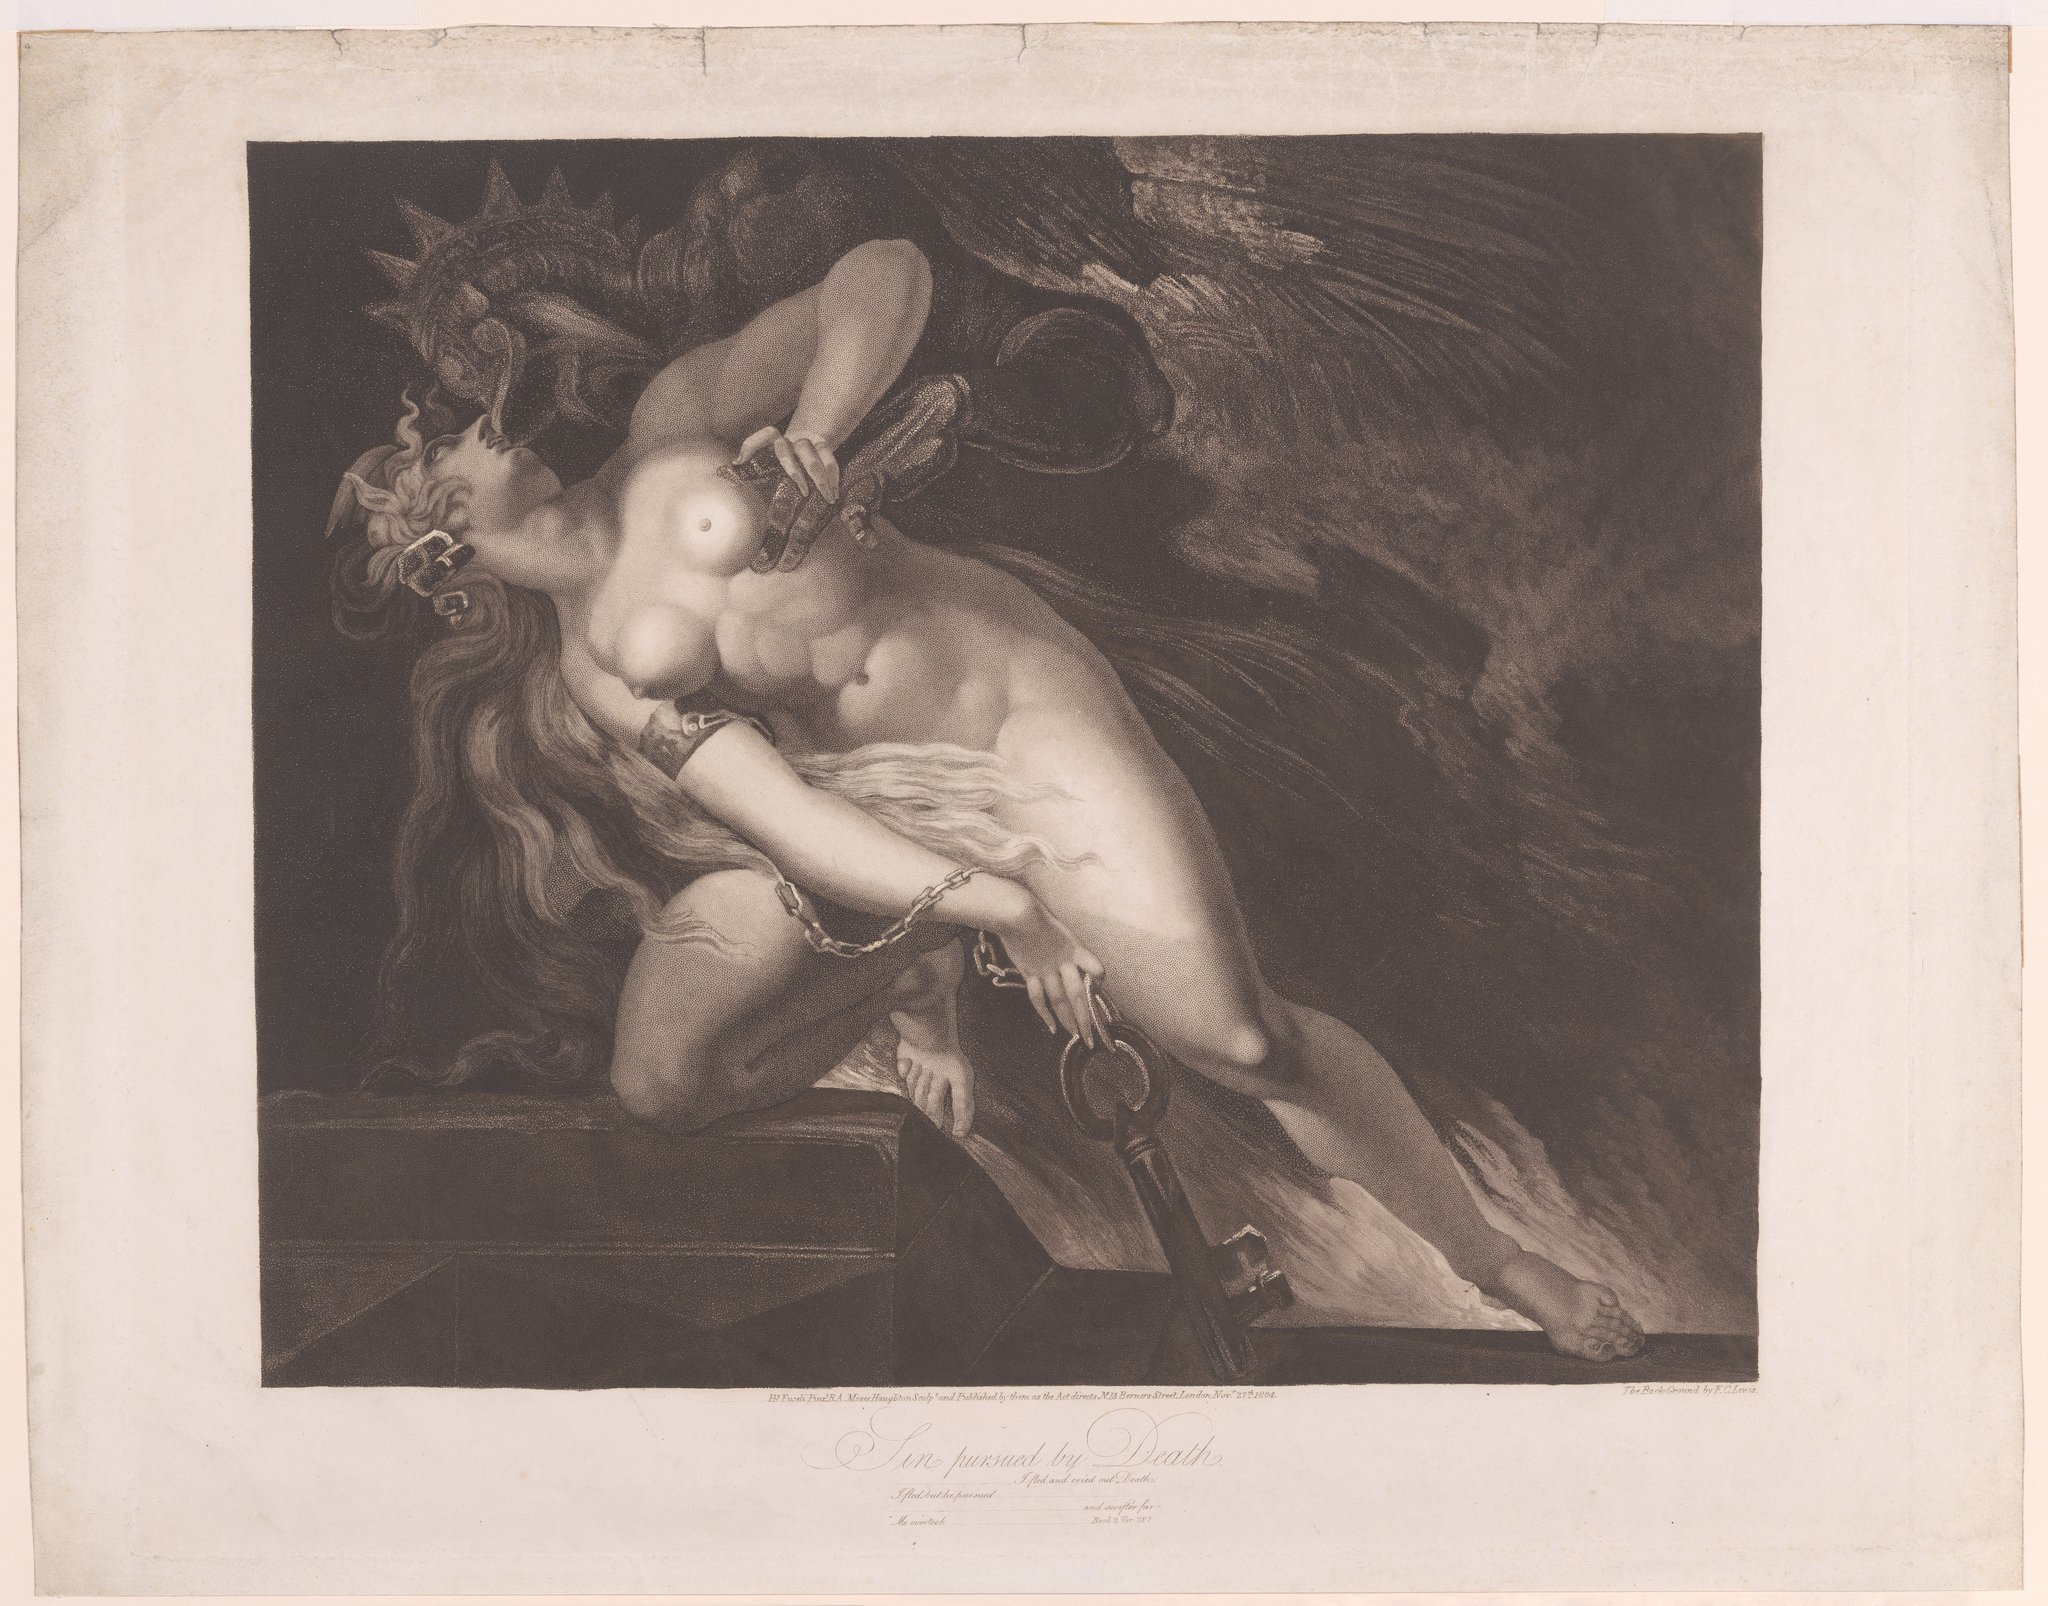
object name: print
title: Sin Pursued by Death (John Milton, Paradise Lost, Book 2, 787, 790-792)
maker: moses haughton the younger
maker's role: engraver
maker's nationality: british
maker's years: 1772-1848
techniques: aquatint, engraving